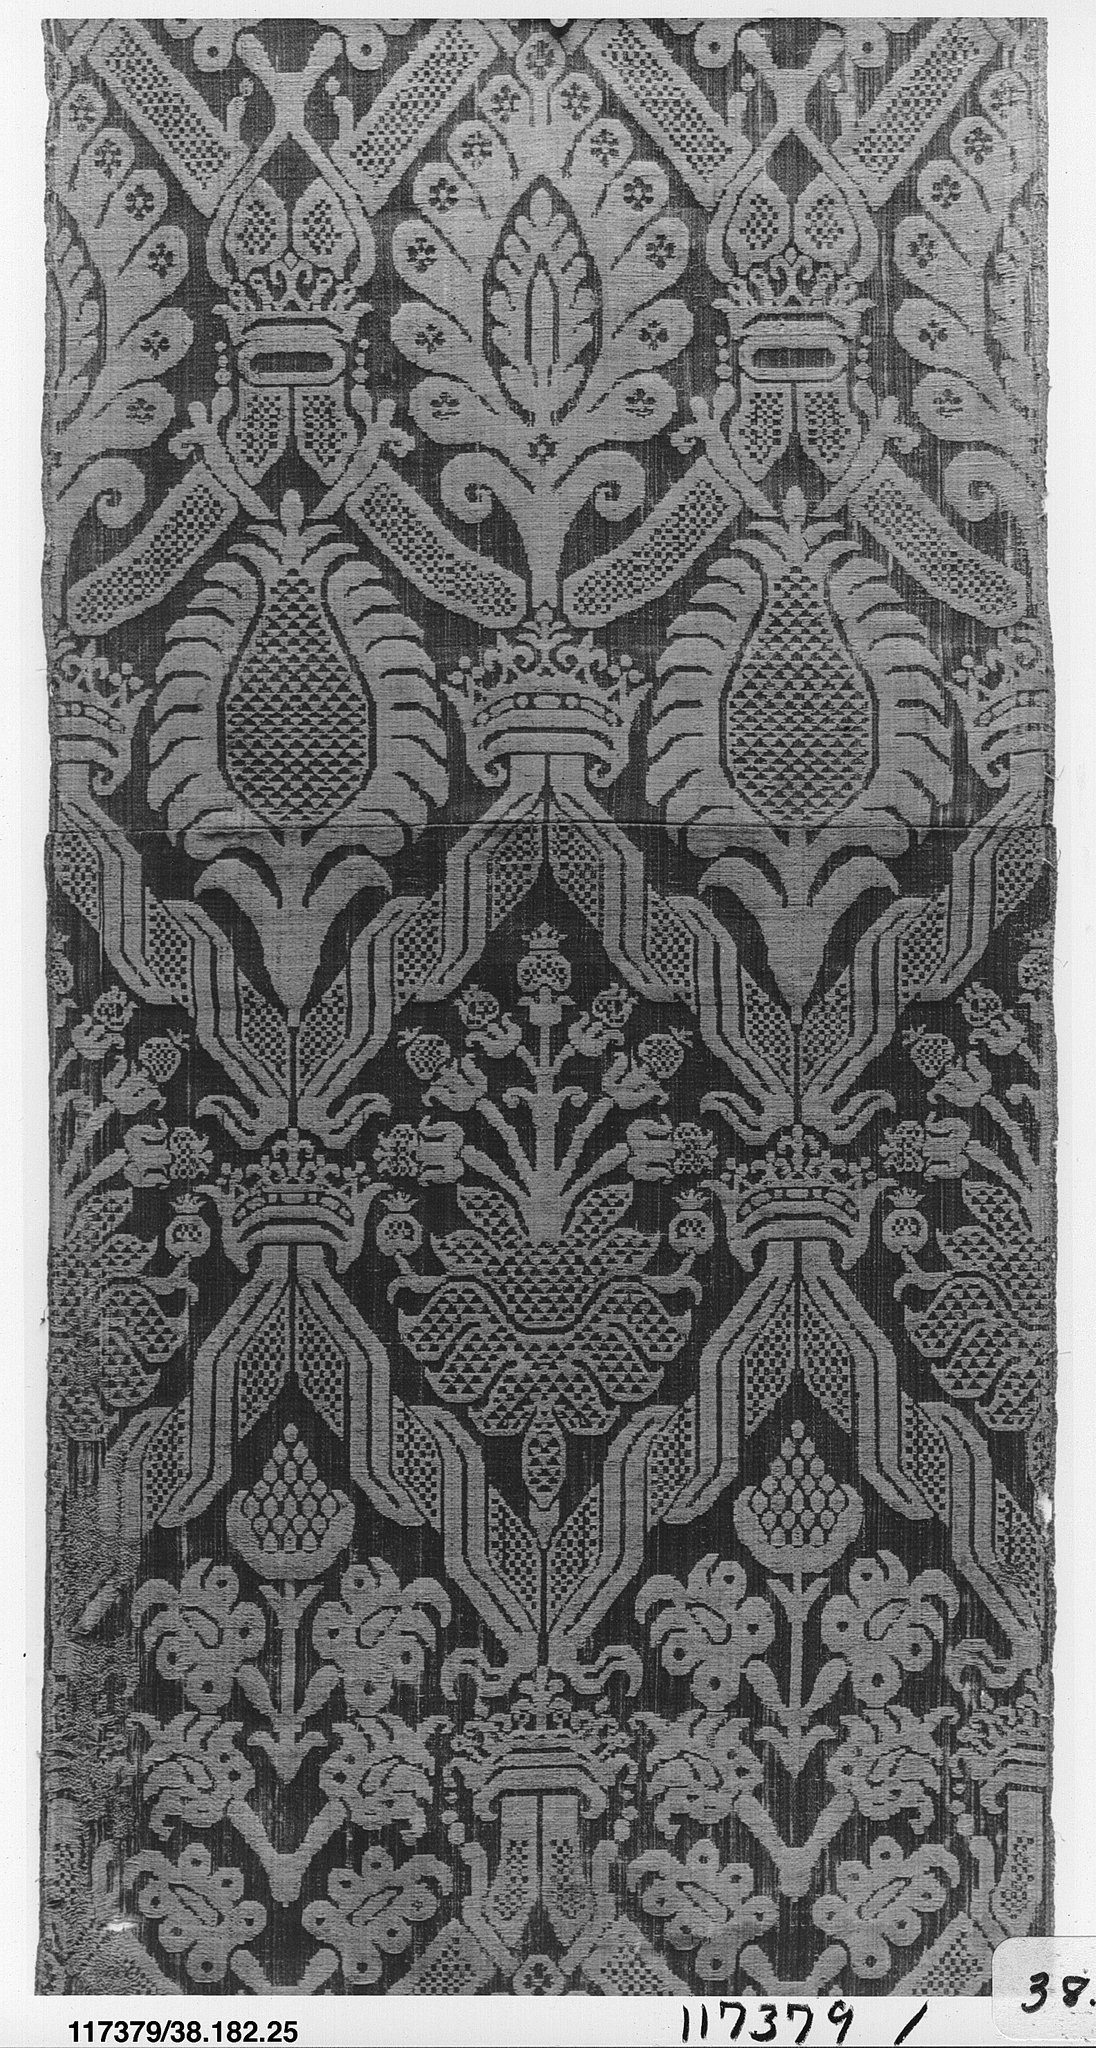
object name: piece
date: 1550-1600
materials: silk